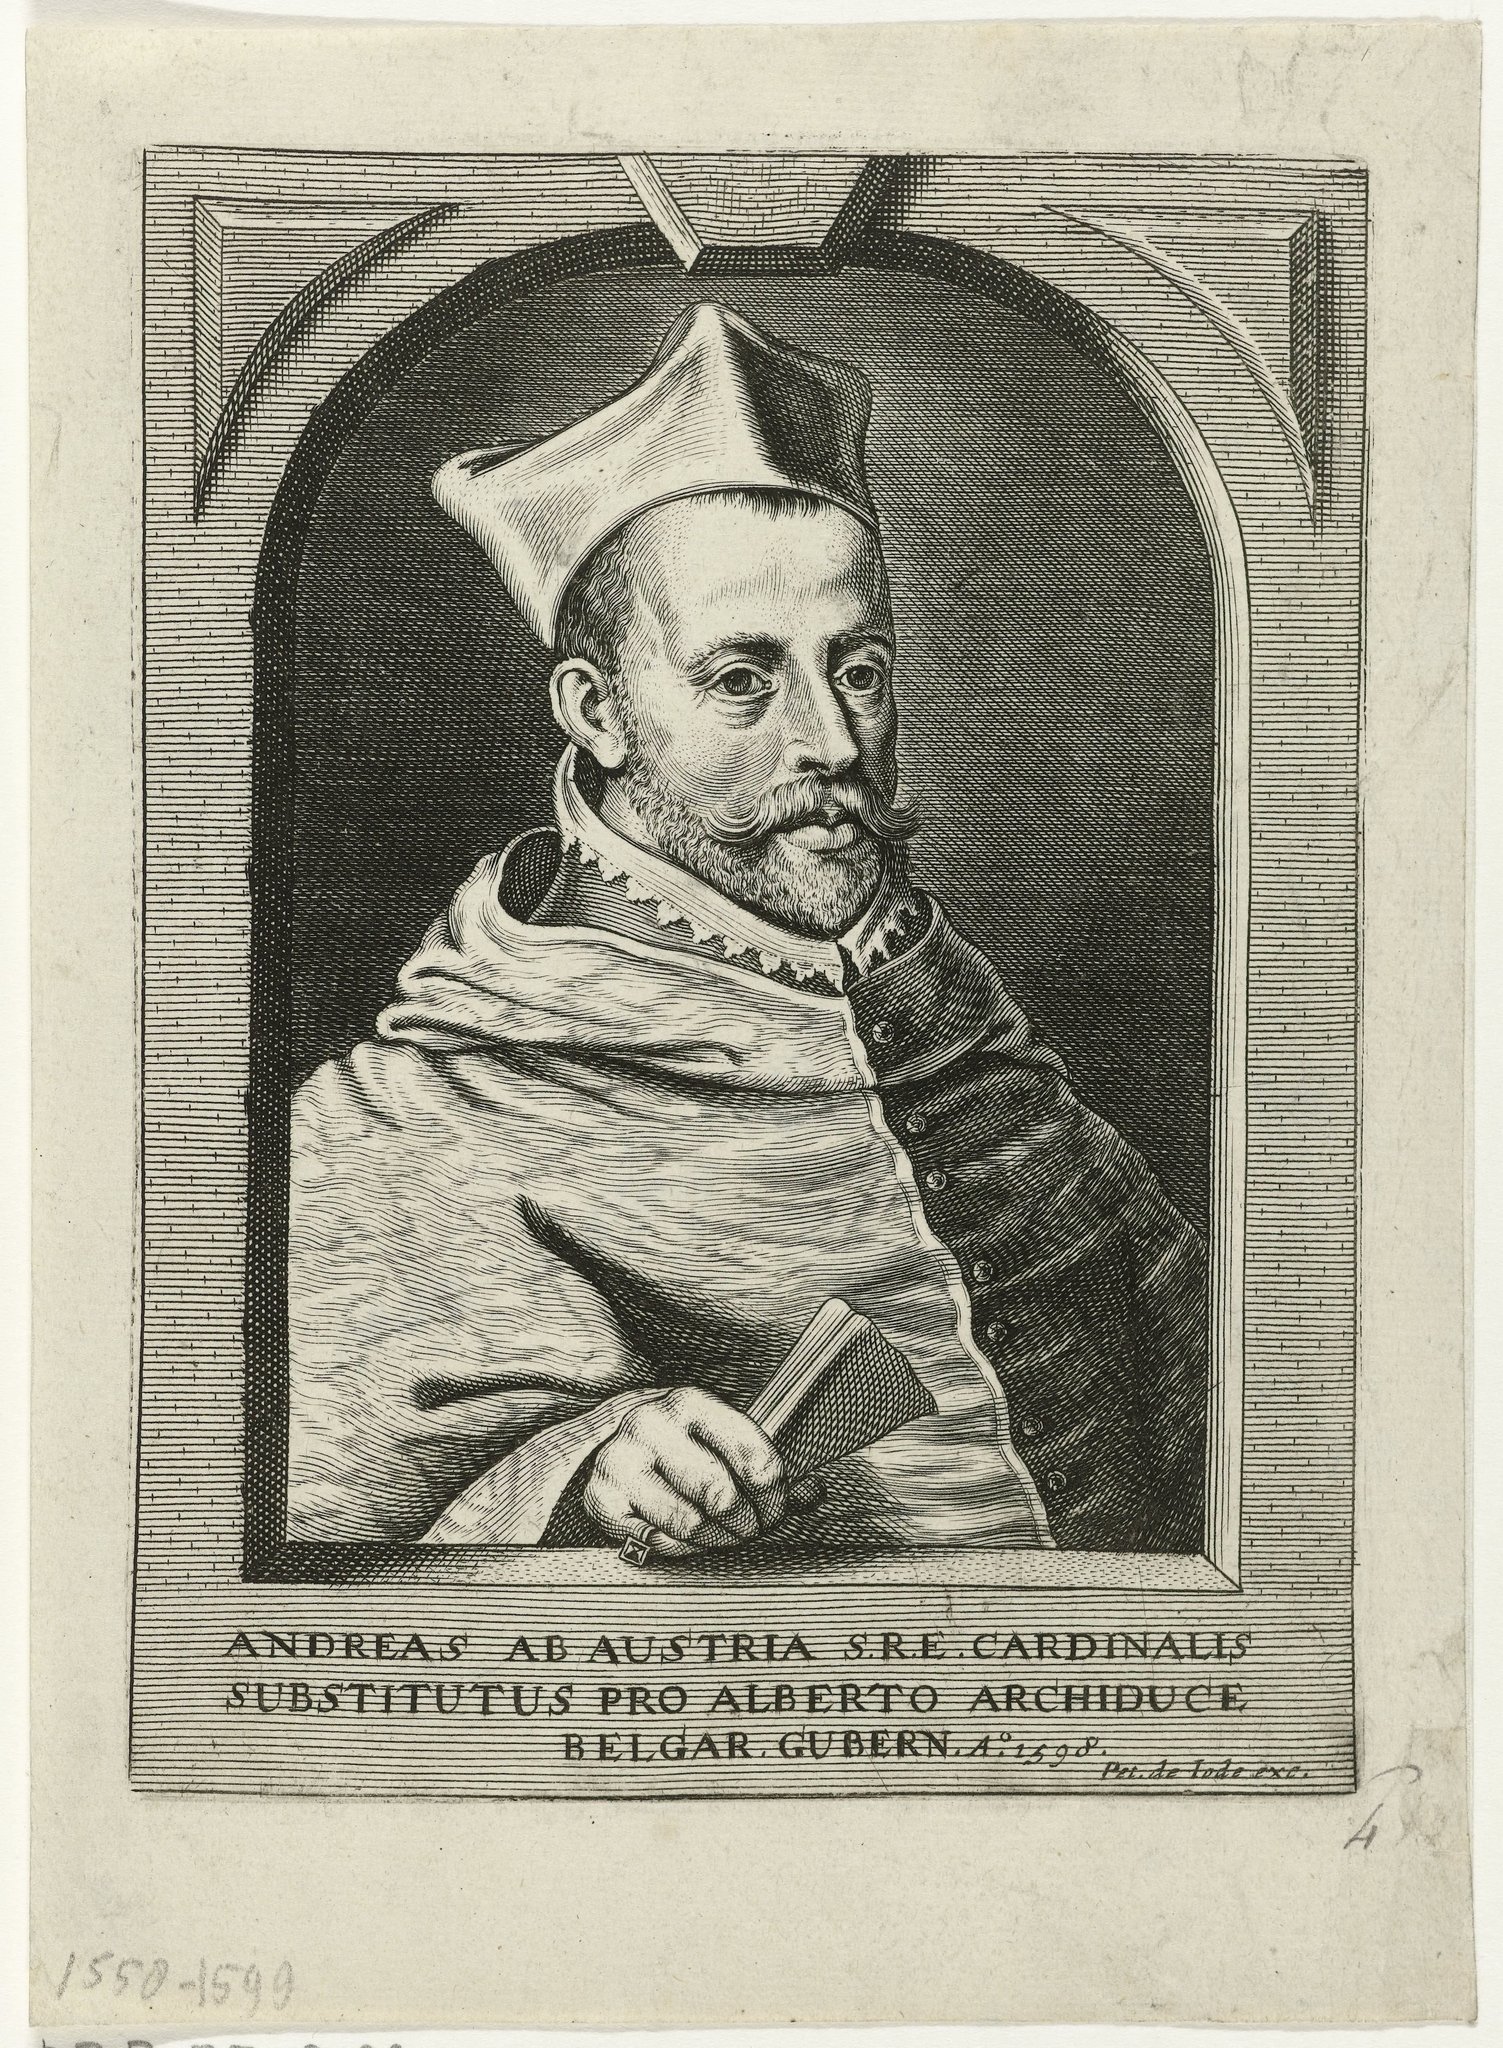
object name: print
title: Theater van bisschoppen, keizers, koningen, hertogen, prinsen, enz.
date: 1628-1670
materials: paper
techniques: engraving, etching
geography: antwerp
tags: head-gear (biretta) (+ men's clothes)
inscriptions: collector's mark: Lugt 2228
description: Busteportret van Andreas van Oostenrijk, met biretta. In zijn rechterhand houdt hij een waaier. Het portret is gevat in een boogvormige omlijsting met een drieregelig onderschrift in het Latijn.